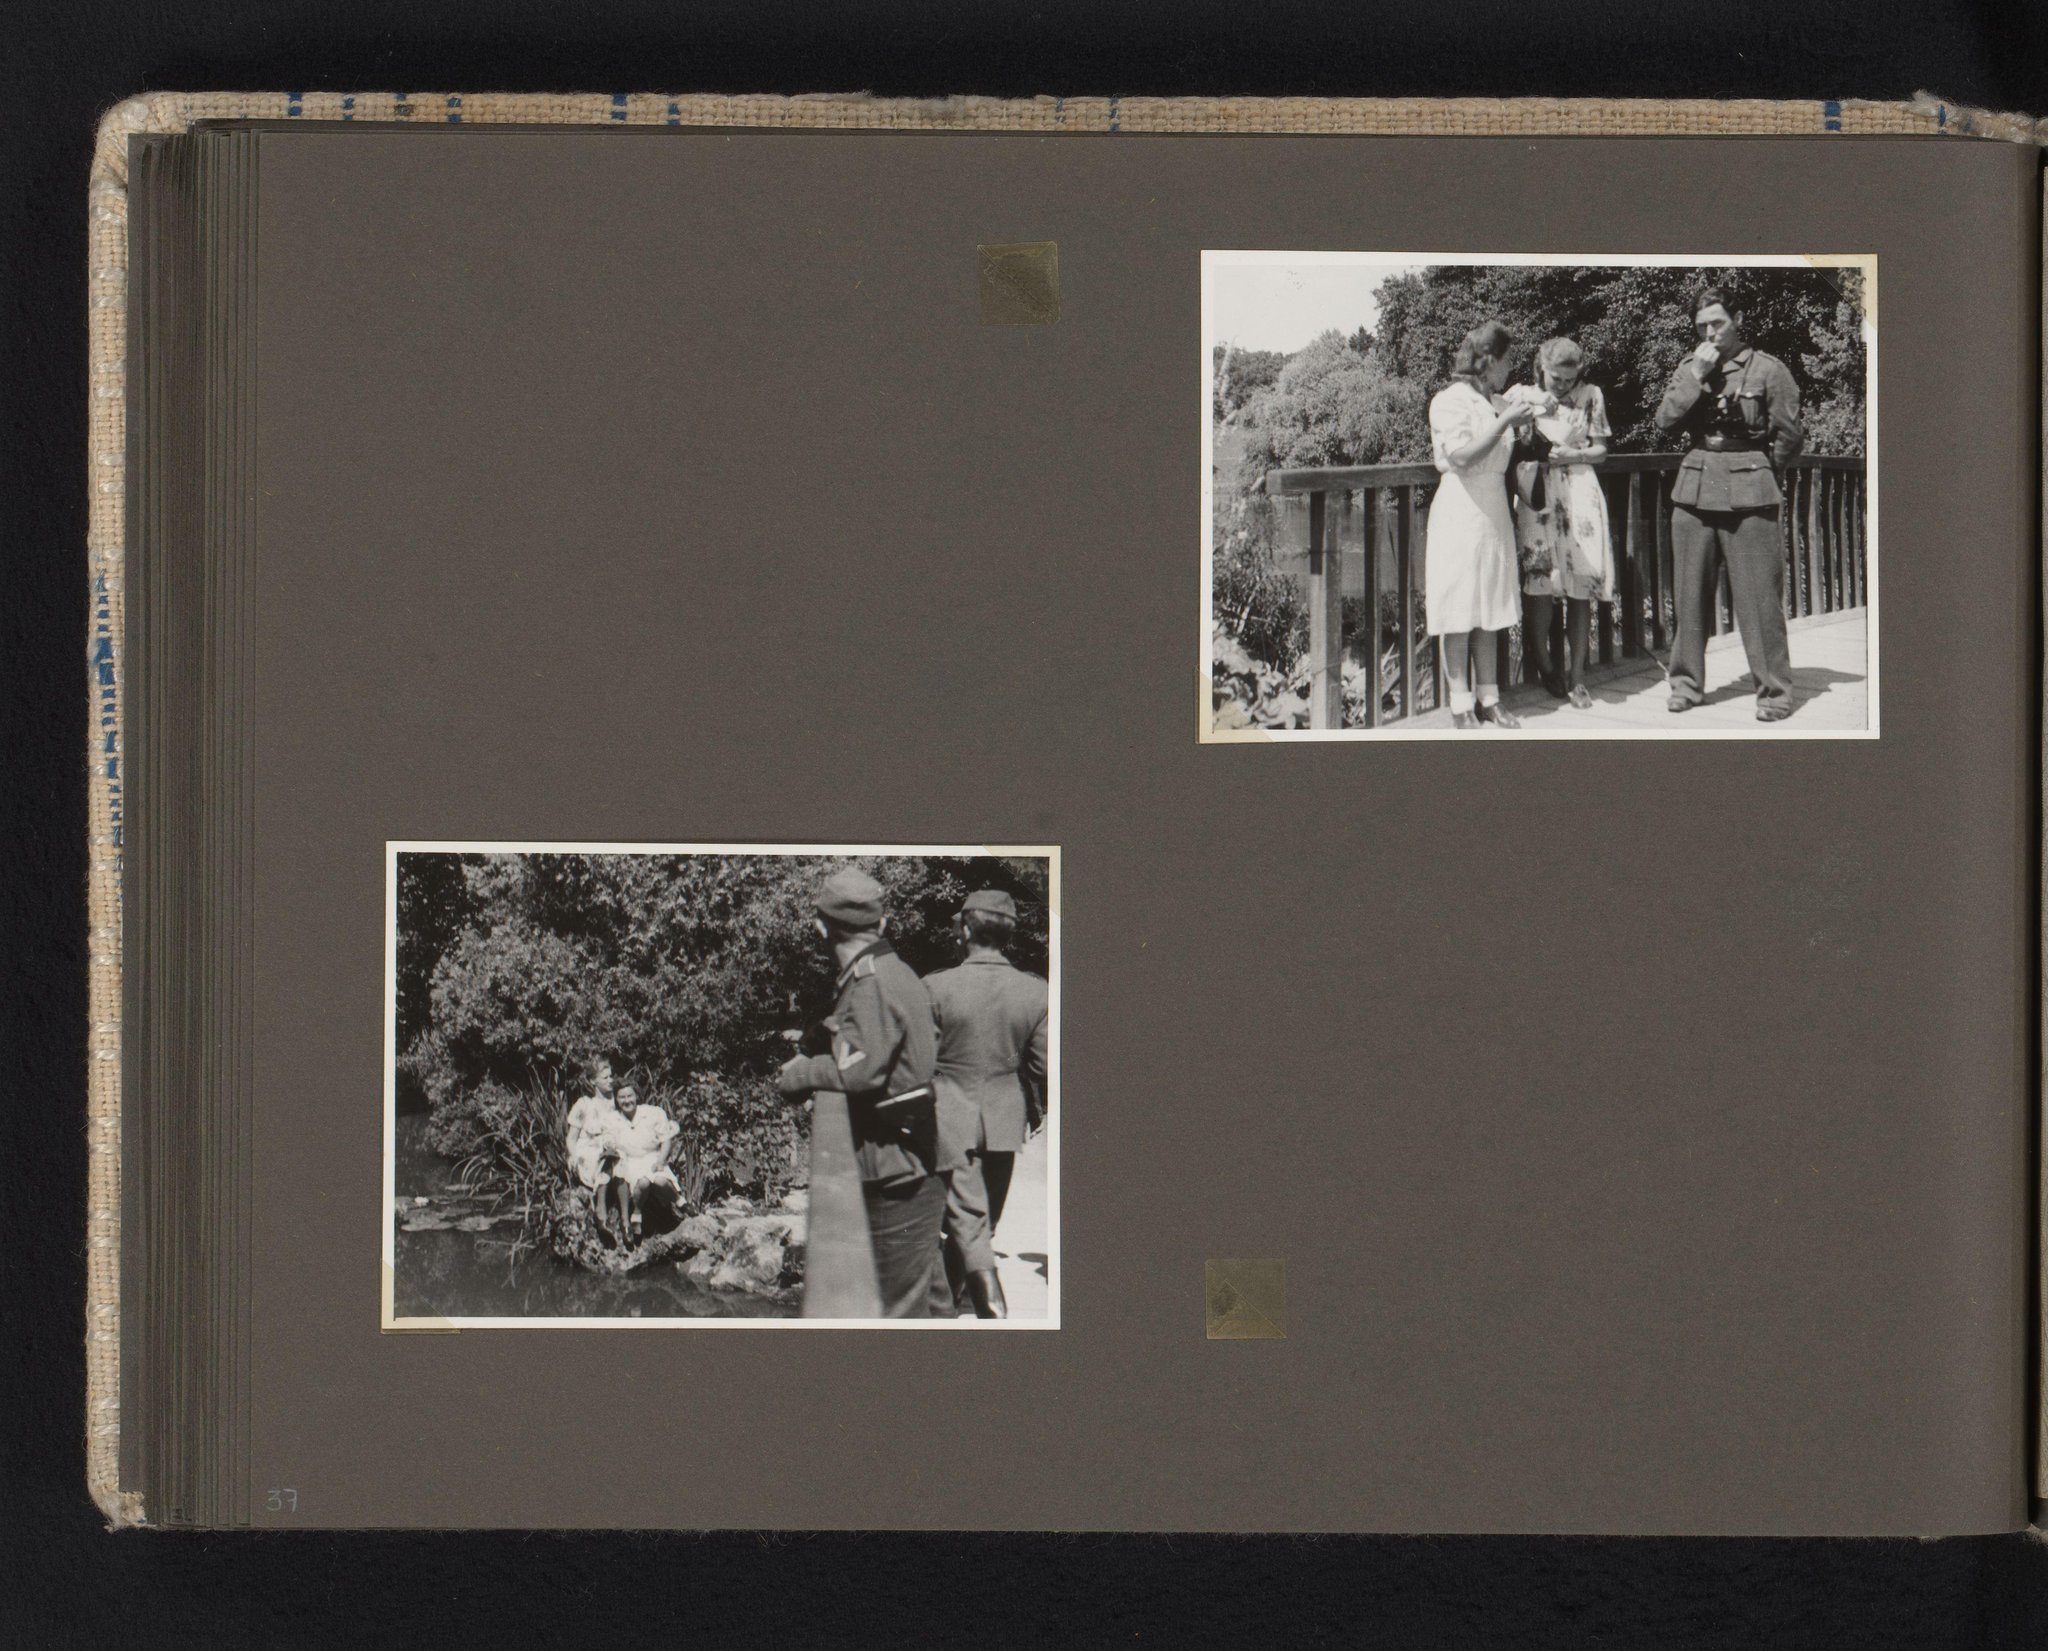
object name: album leaf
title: Zagreb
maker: Anonymous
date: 1943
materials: cardboard, photographic support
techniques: gelatin silver print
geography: zagreb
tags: leave ~ the soldier off duty, occupation ~ war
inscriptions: inscription: ‘Maksimir 25,7.43’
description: Albumblad met twee foto's van militairen en jonge vrouwen in het park Maksimir te Agram (Zagreb), 25 juli 1943. Onderdeel van het fotoalbum Abrechnungsintendantur van de Wehrmacht 1941-1943.